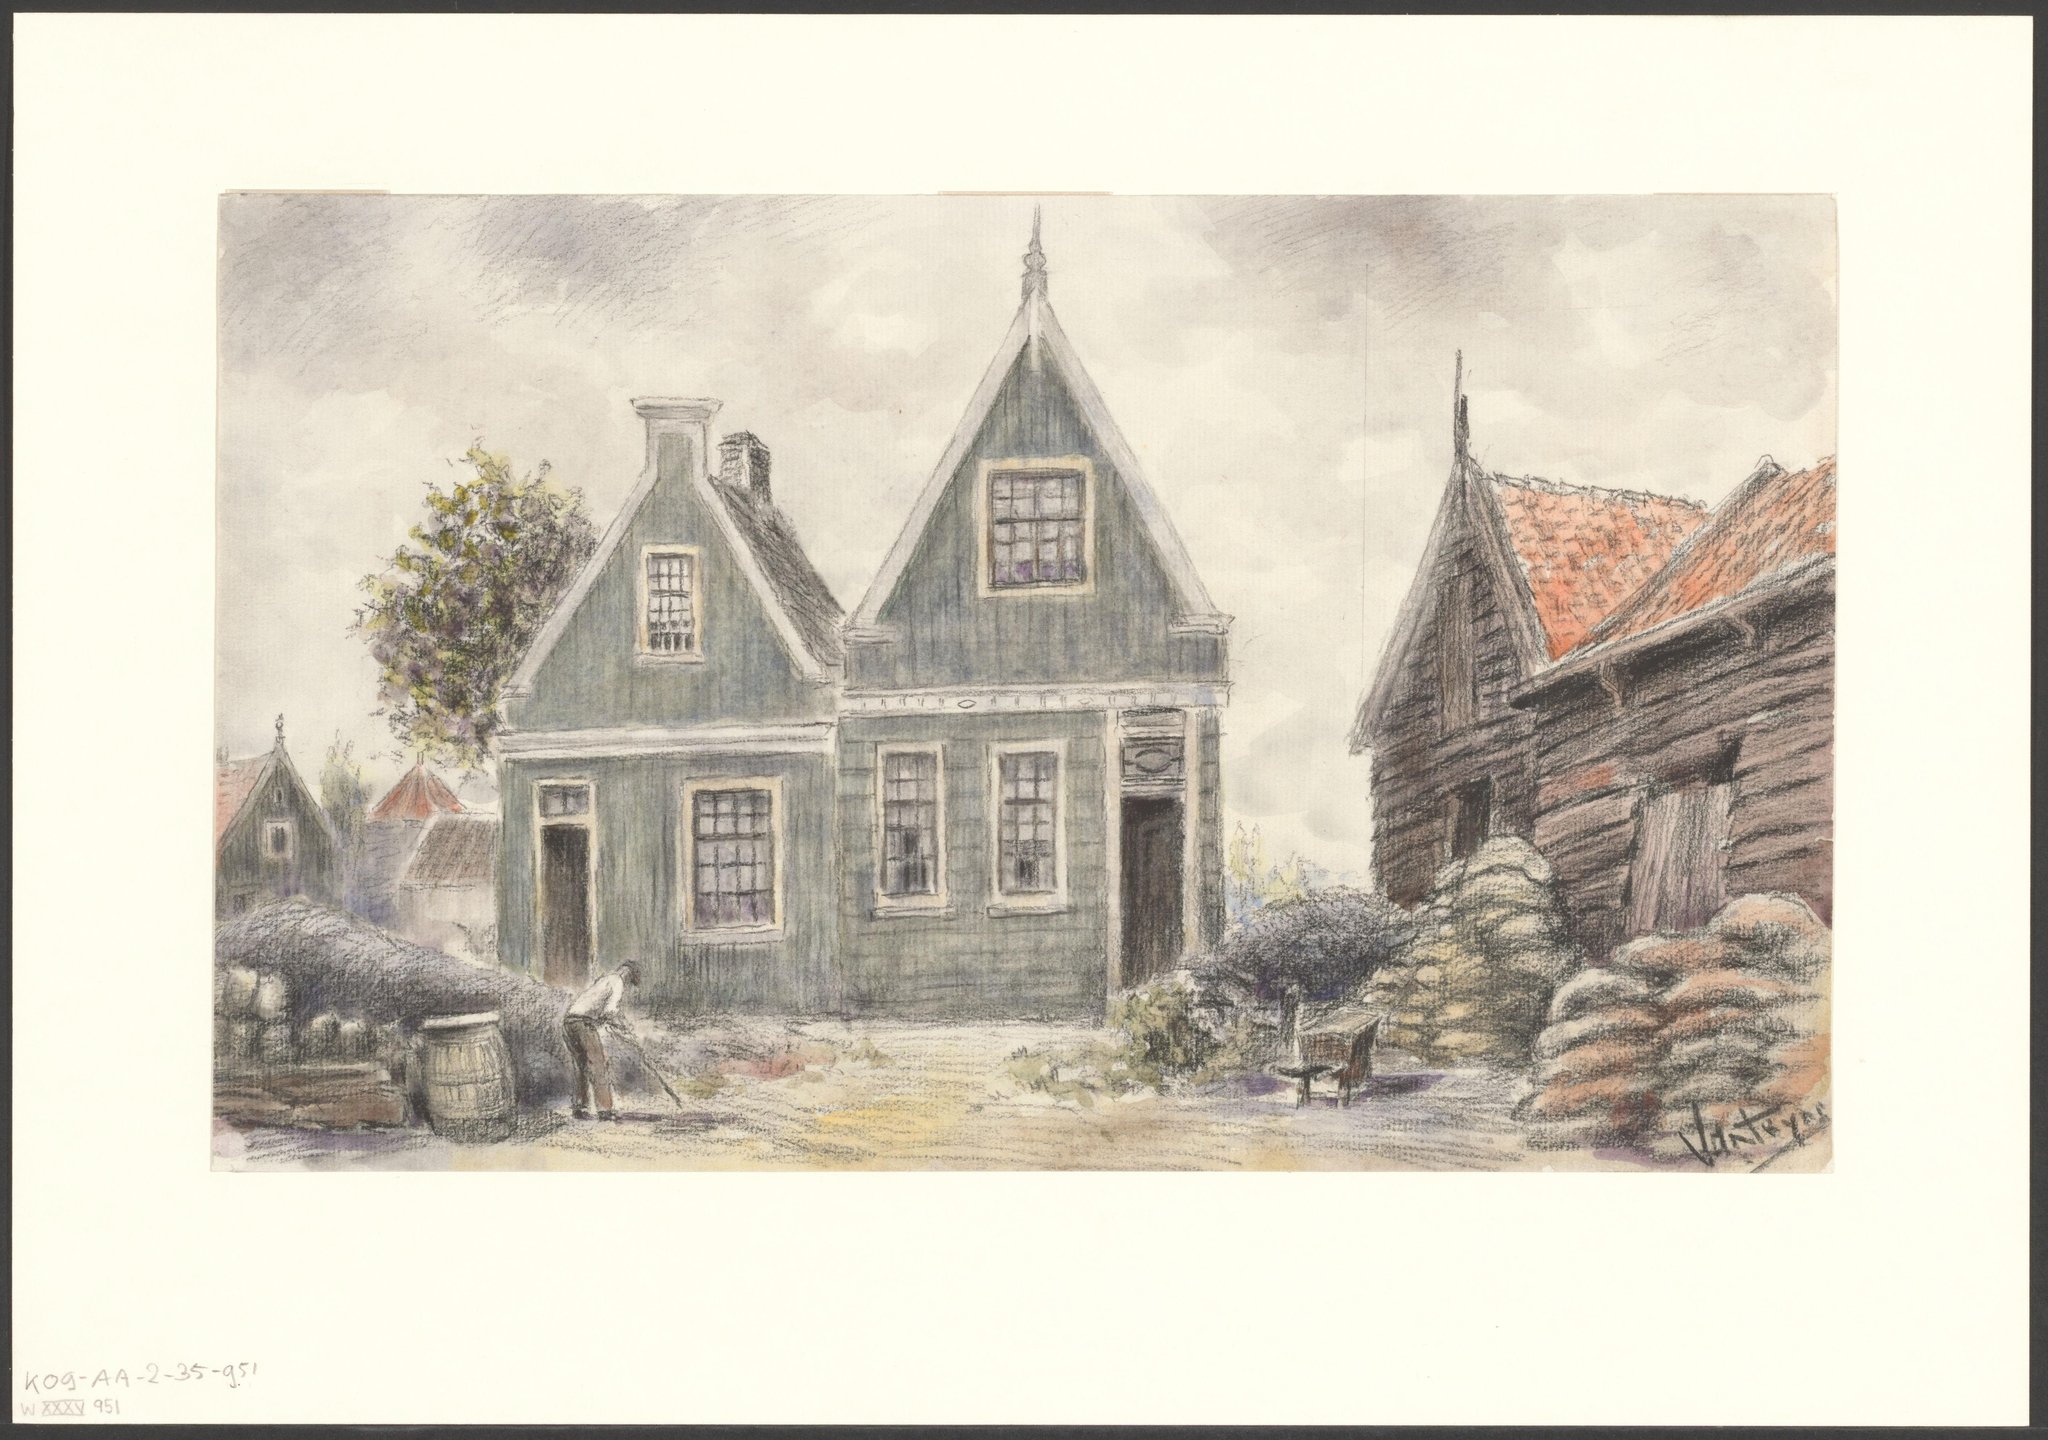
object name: drawing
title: Gezicht op het Sluispad te Nieuwendam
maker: anthonie van teijn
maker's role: draughtsman, painter, print maker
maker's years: 1863-1943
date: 1906-1928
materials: chalk, paper, watercolor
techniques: brush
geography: amsterdam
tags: village, road, path, the usual house or row of houses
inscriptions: signature: ‘VanTeyne’, collector's mark: Lugt 800a, inscription: ‘Kolenha[...] op het pad tusschen Kerkpad en Nieuwendammerstr Juni 1928’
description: Tekening binnen de Atlas Van Eck ingedeeld op wijknummer 35.